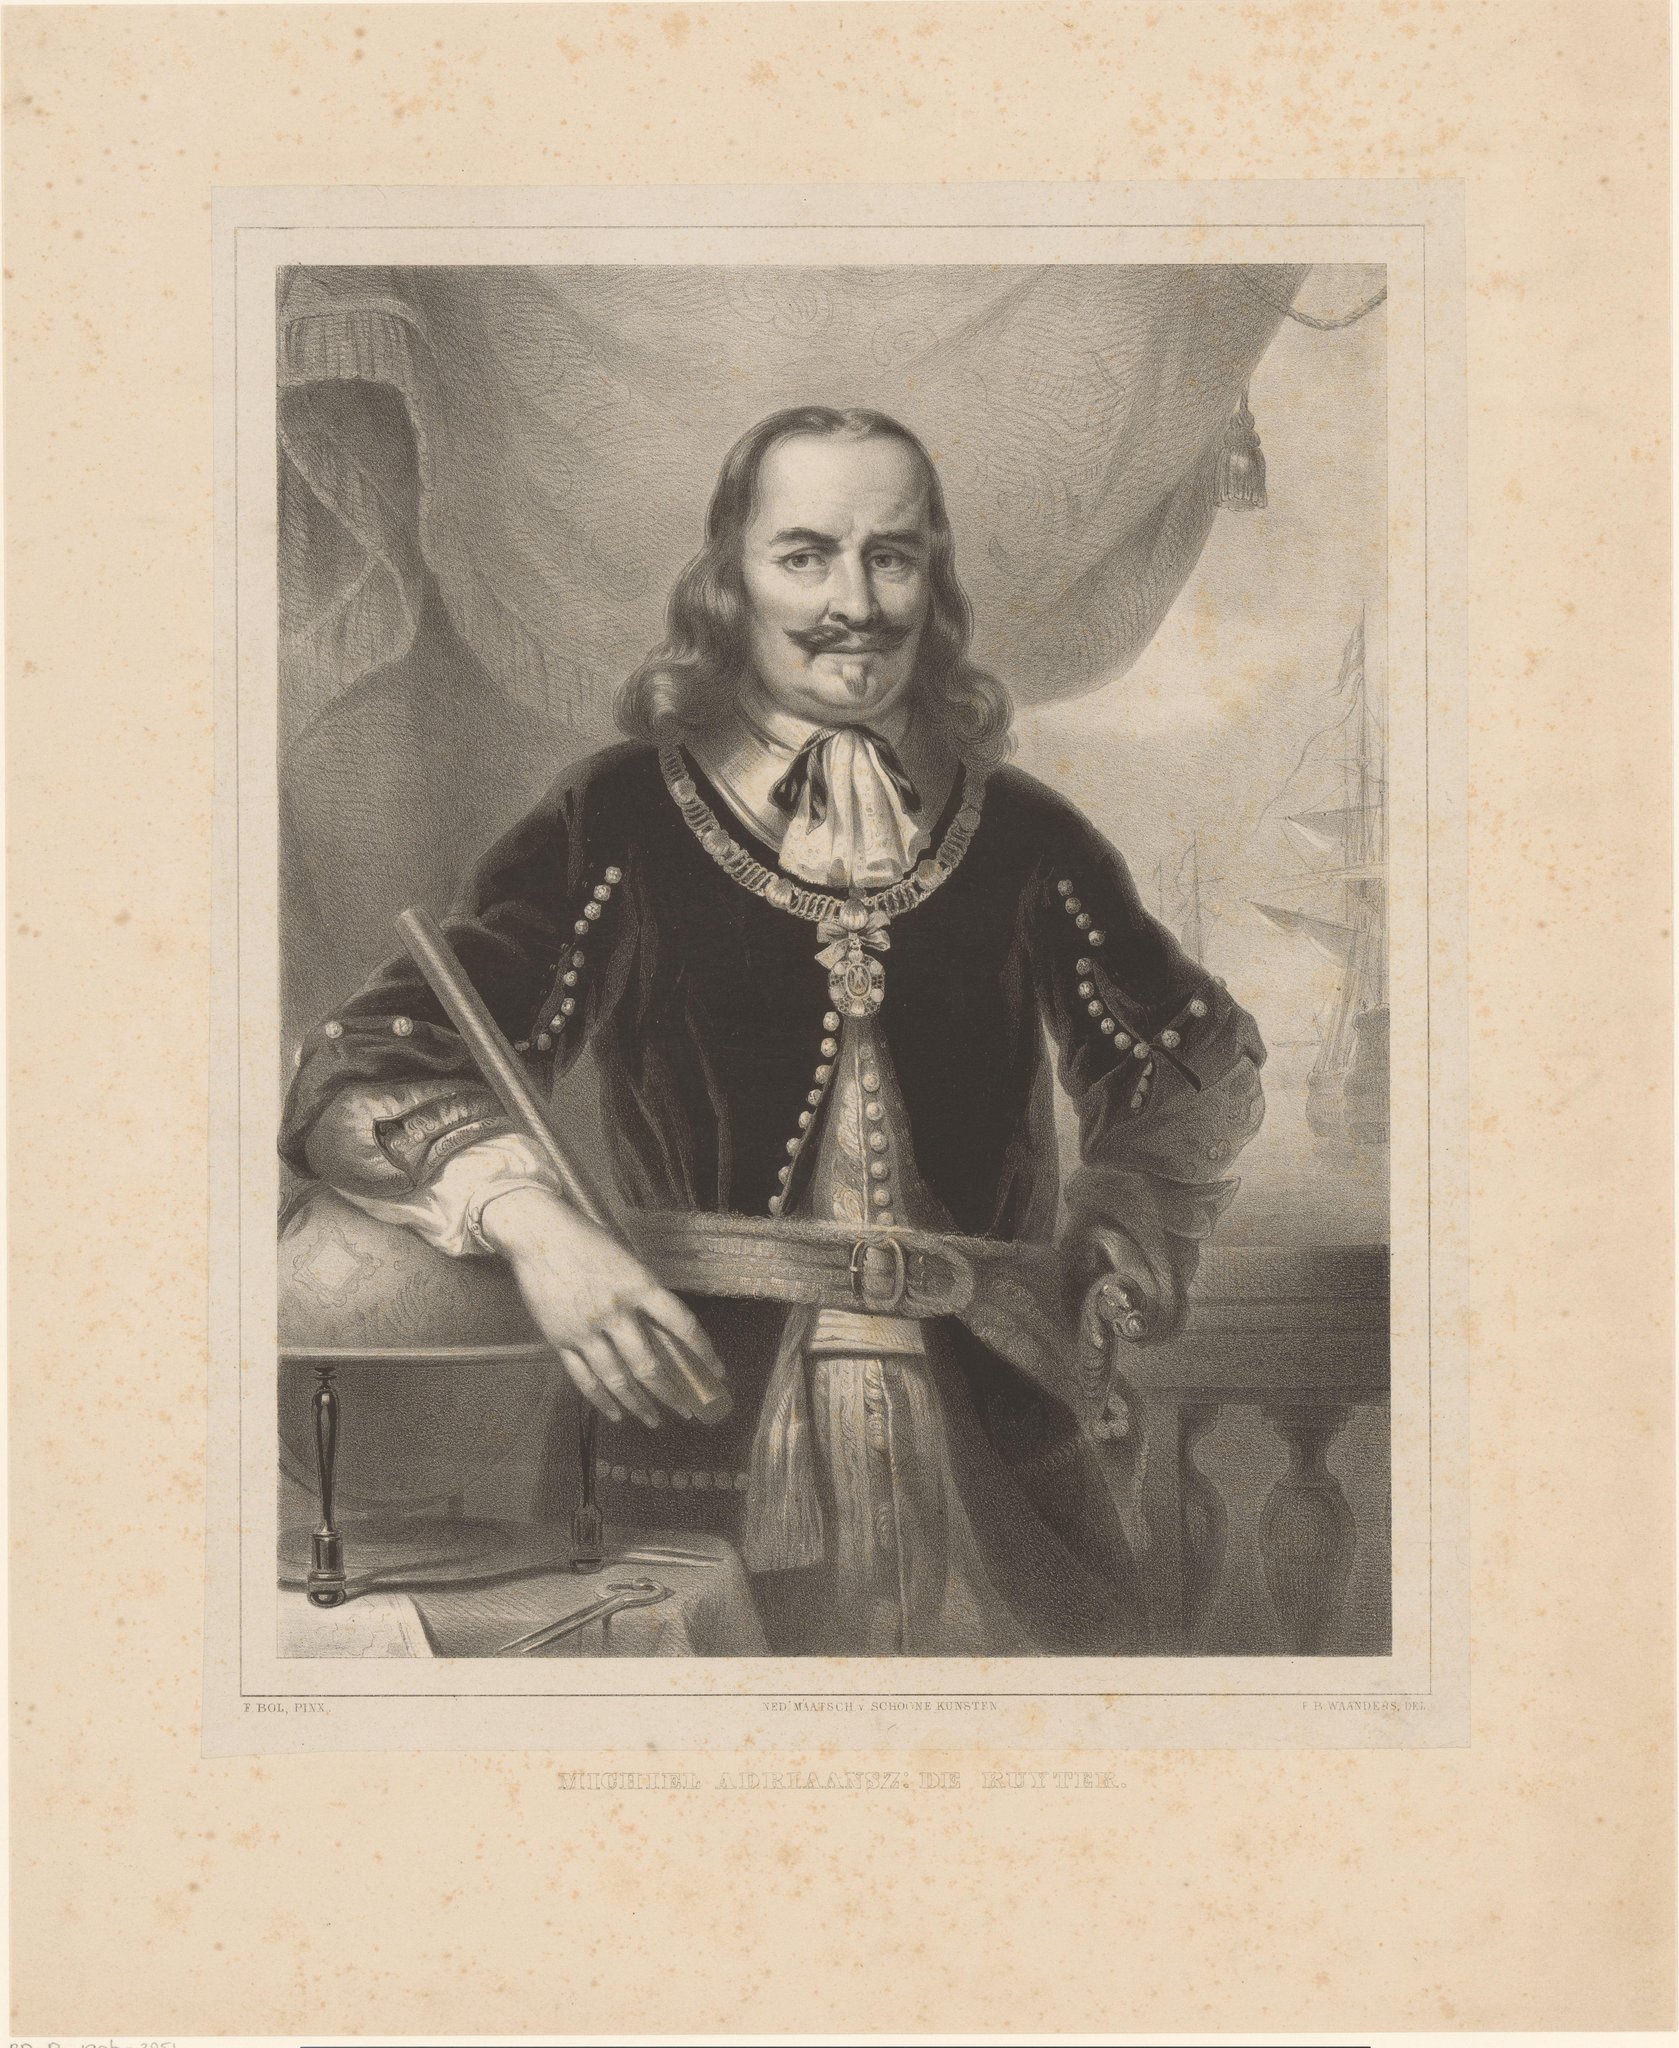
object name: print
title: Portret van Michiel Adriaenszoon de Ruyter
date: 1840-1843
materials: paper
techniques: lithograph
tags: flushing, michiel adriaenszoon de ruyter, historical persons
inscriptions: collector's mark: Lugt 2228